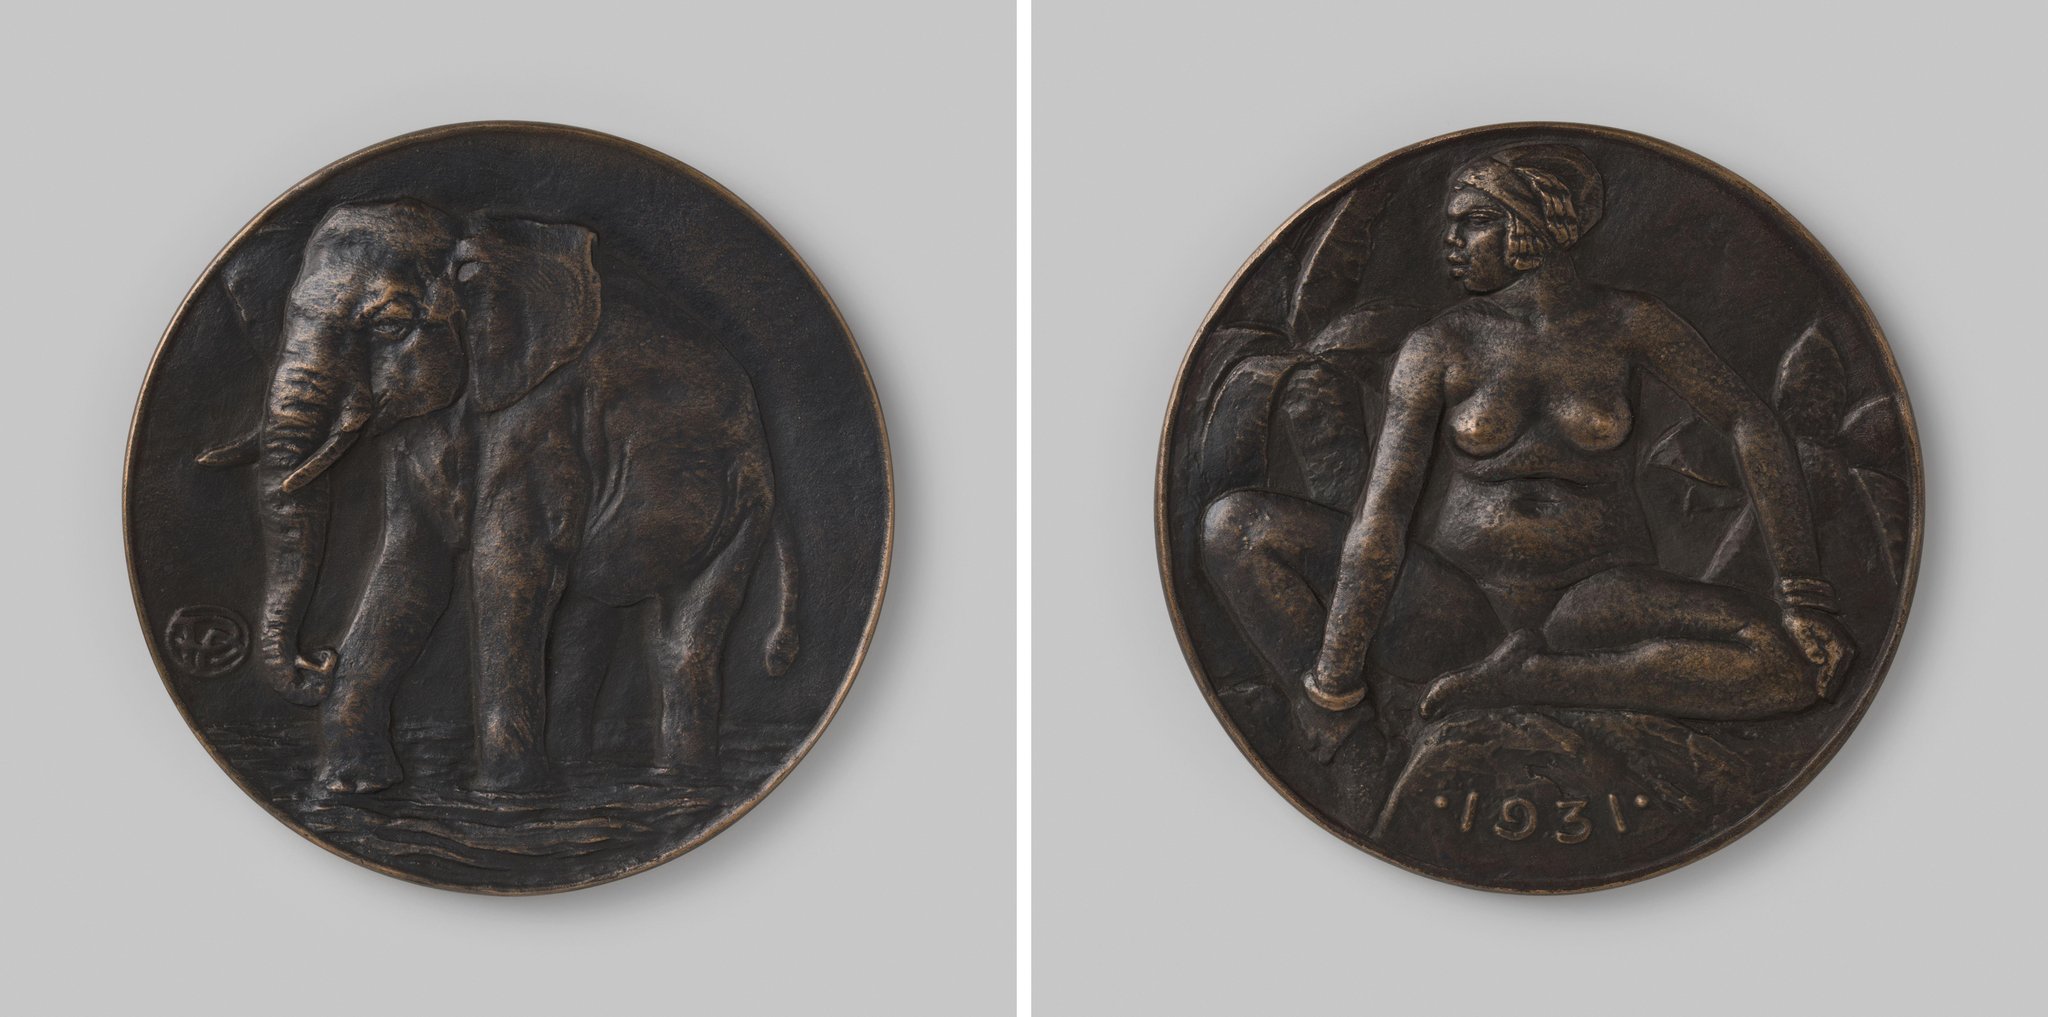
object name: history medal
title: De koloniën van Frankrijk (1931)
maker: a. pommier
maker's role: modelleur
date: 1930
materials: bronze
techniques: casting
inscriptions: number: ‘(vierkant merk) 132’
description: Bronzen penning, op de voorzijde een olifant half naar links, op de keerzijde een zittende Afrikaanse vrouw te midden van palmbomen, met onderaan een jaartal.